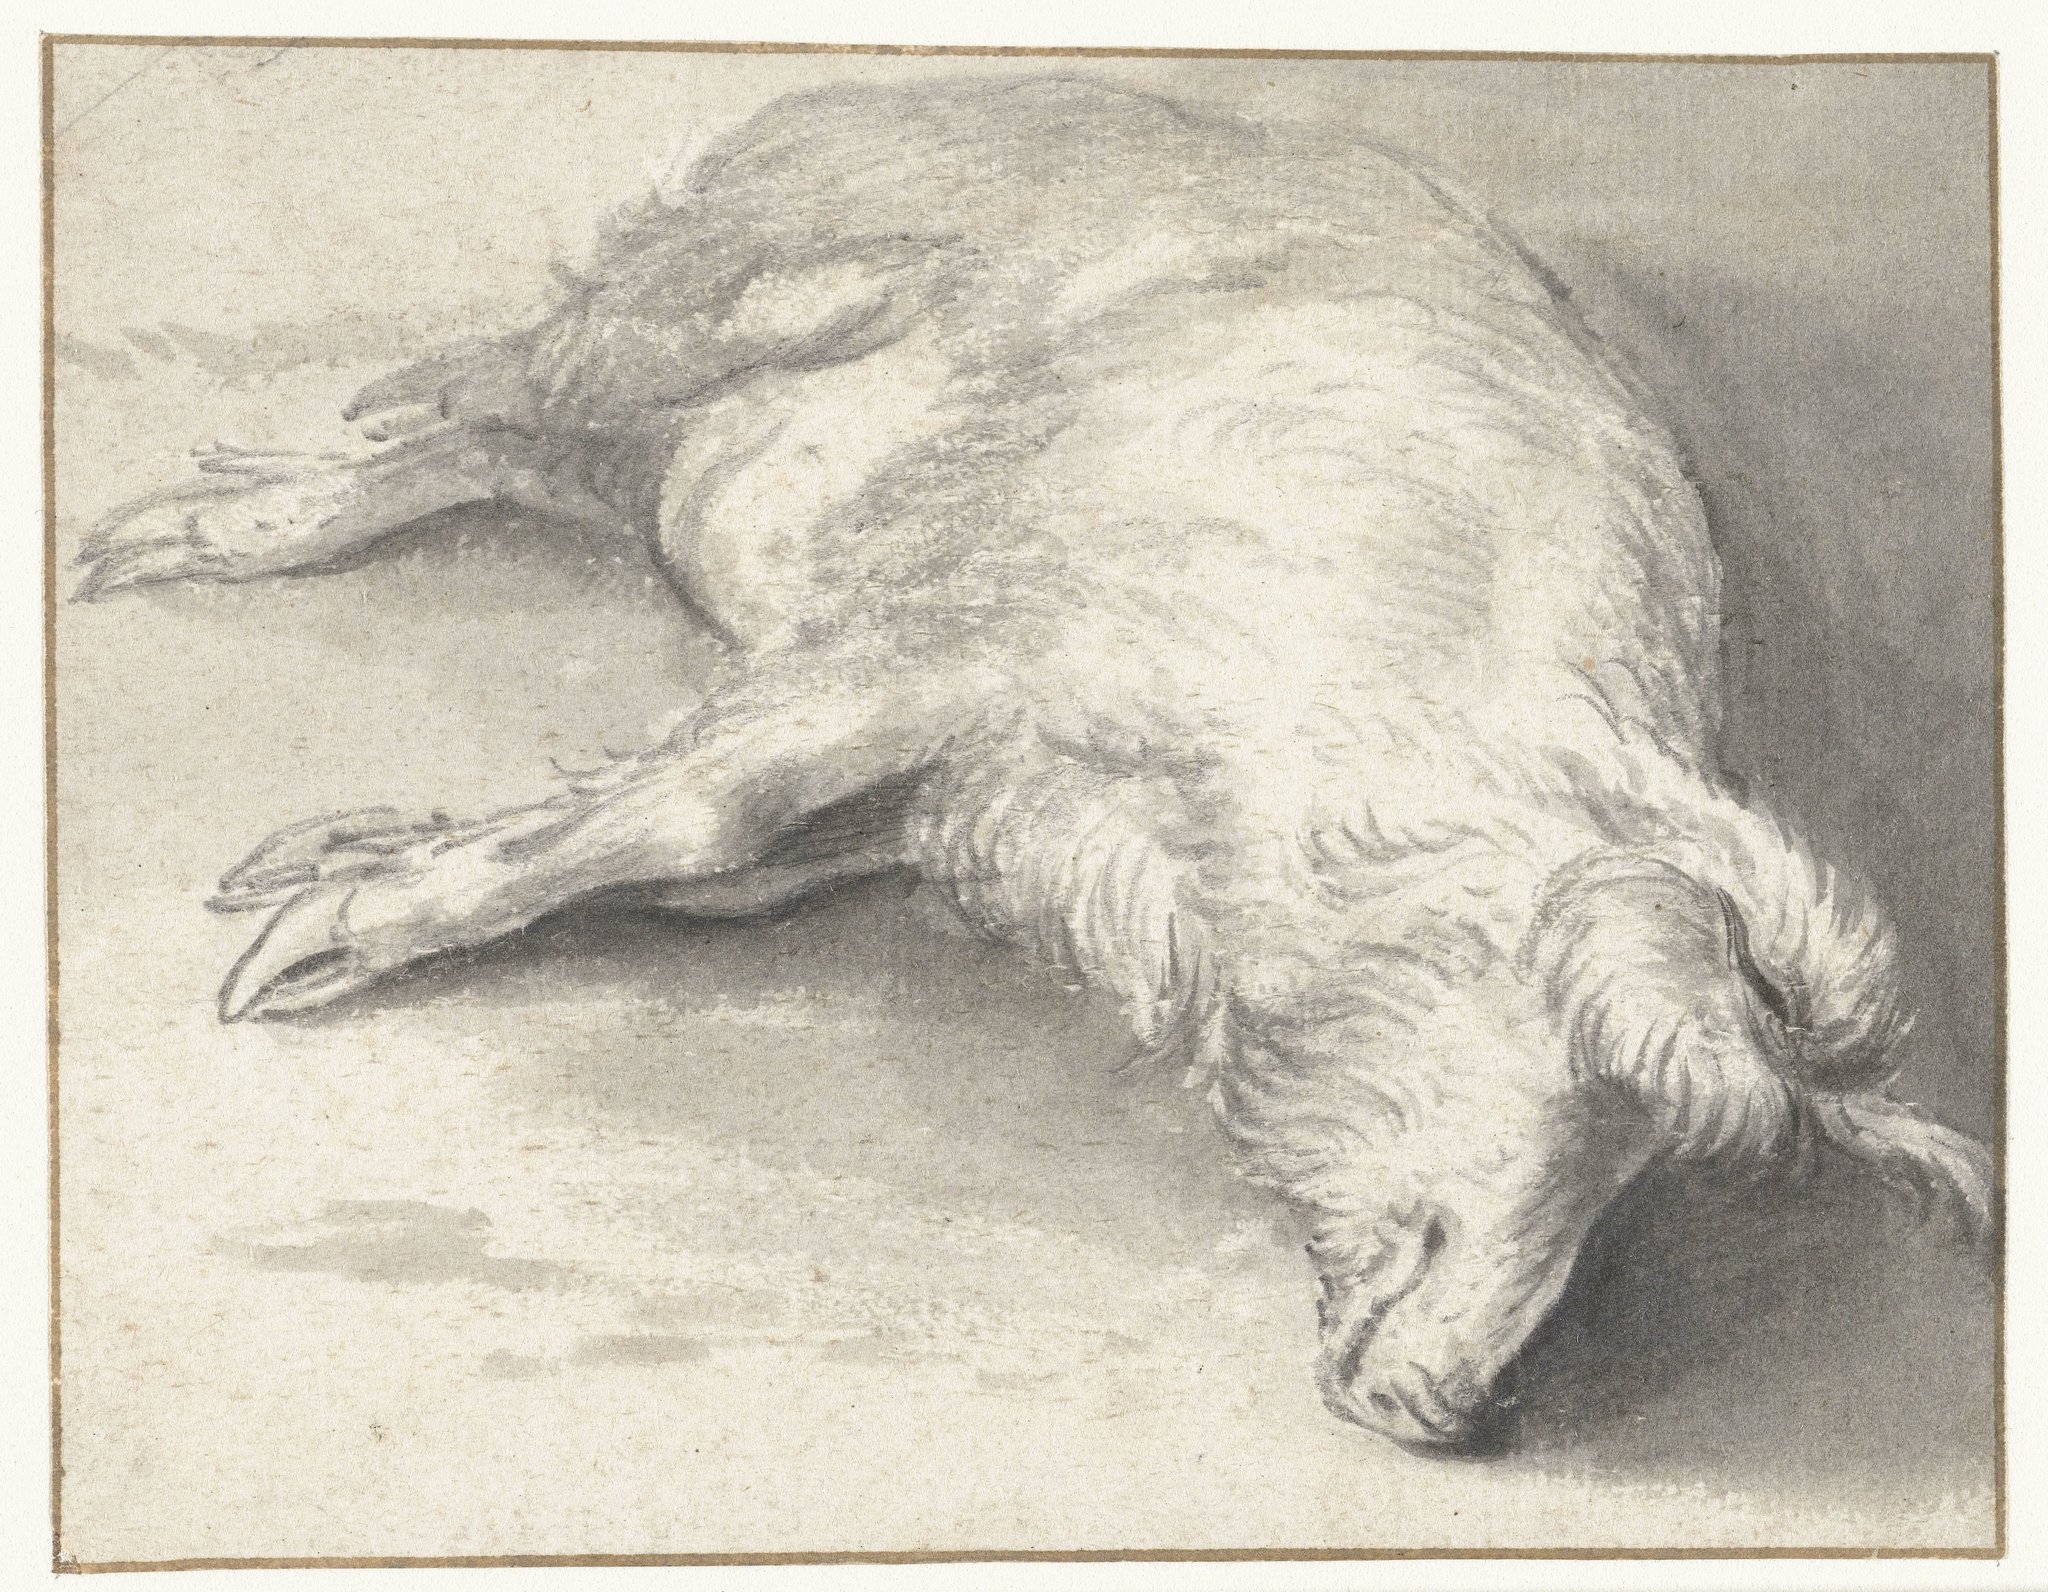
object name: drawing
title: Recumbent Pig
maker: adriaen verdoel i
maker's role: draughtsman, painter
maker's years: 1623-1675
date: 1650-1675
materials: paper, pencil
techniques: brush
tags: pig